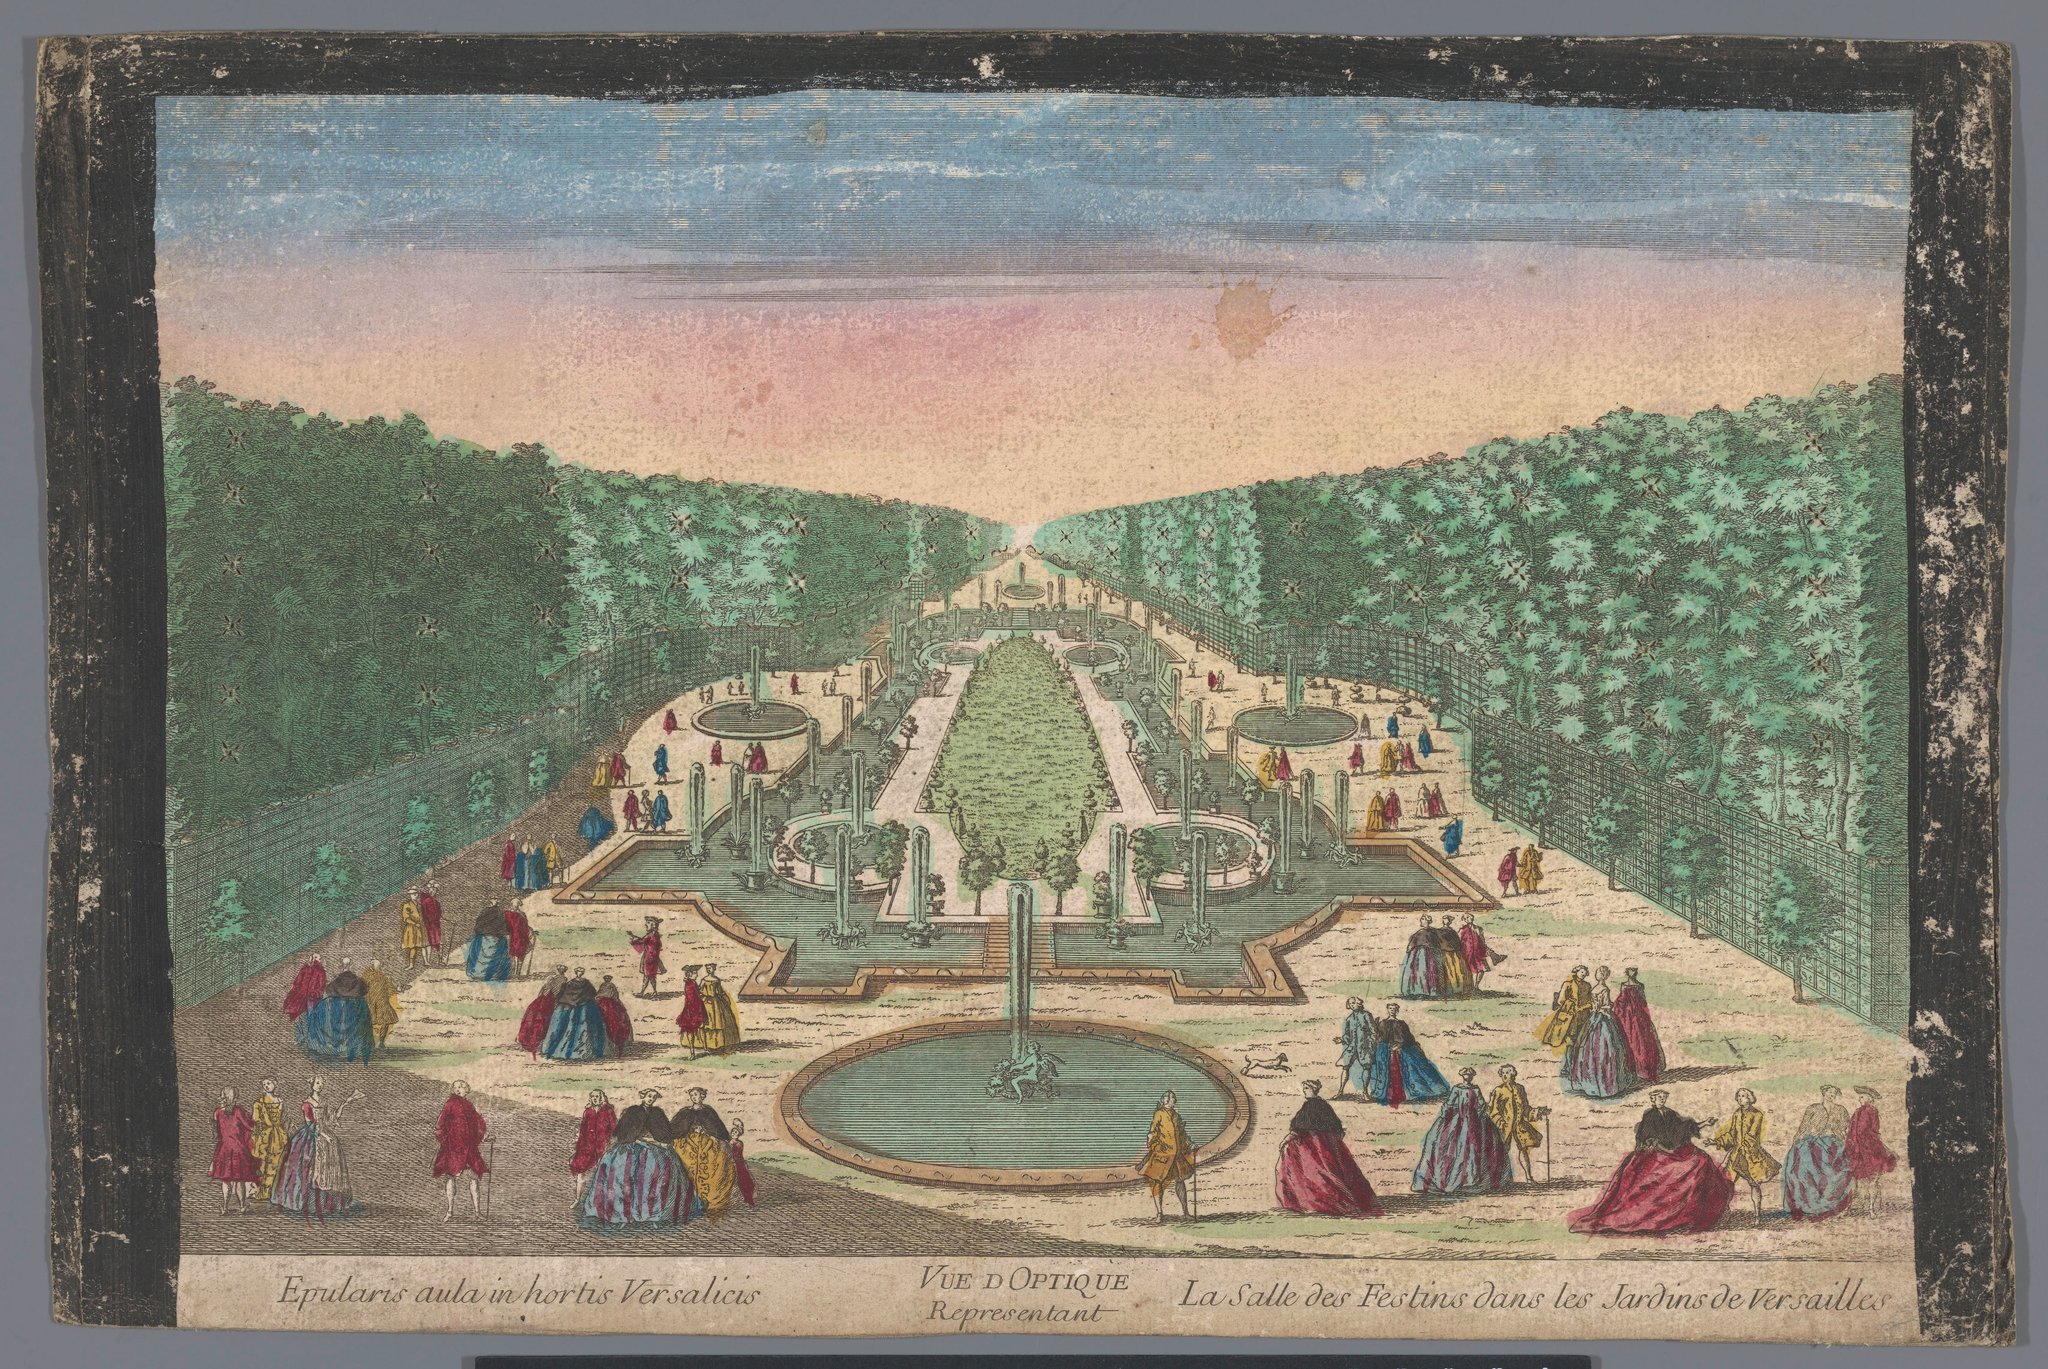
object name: print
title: Vue doptique representant la Salle des Festins dans les Jardins de Versailles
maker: Anonymous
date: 1700-1799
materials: cardboard, paint, paper, watercolor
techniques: brush, cutting, etching, perforating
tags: garden, garden fountain, ornamental plants